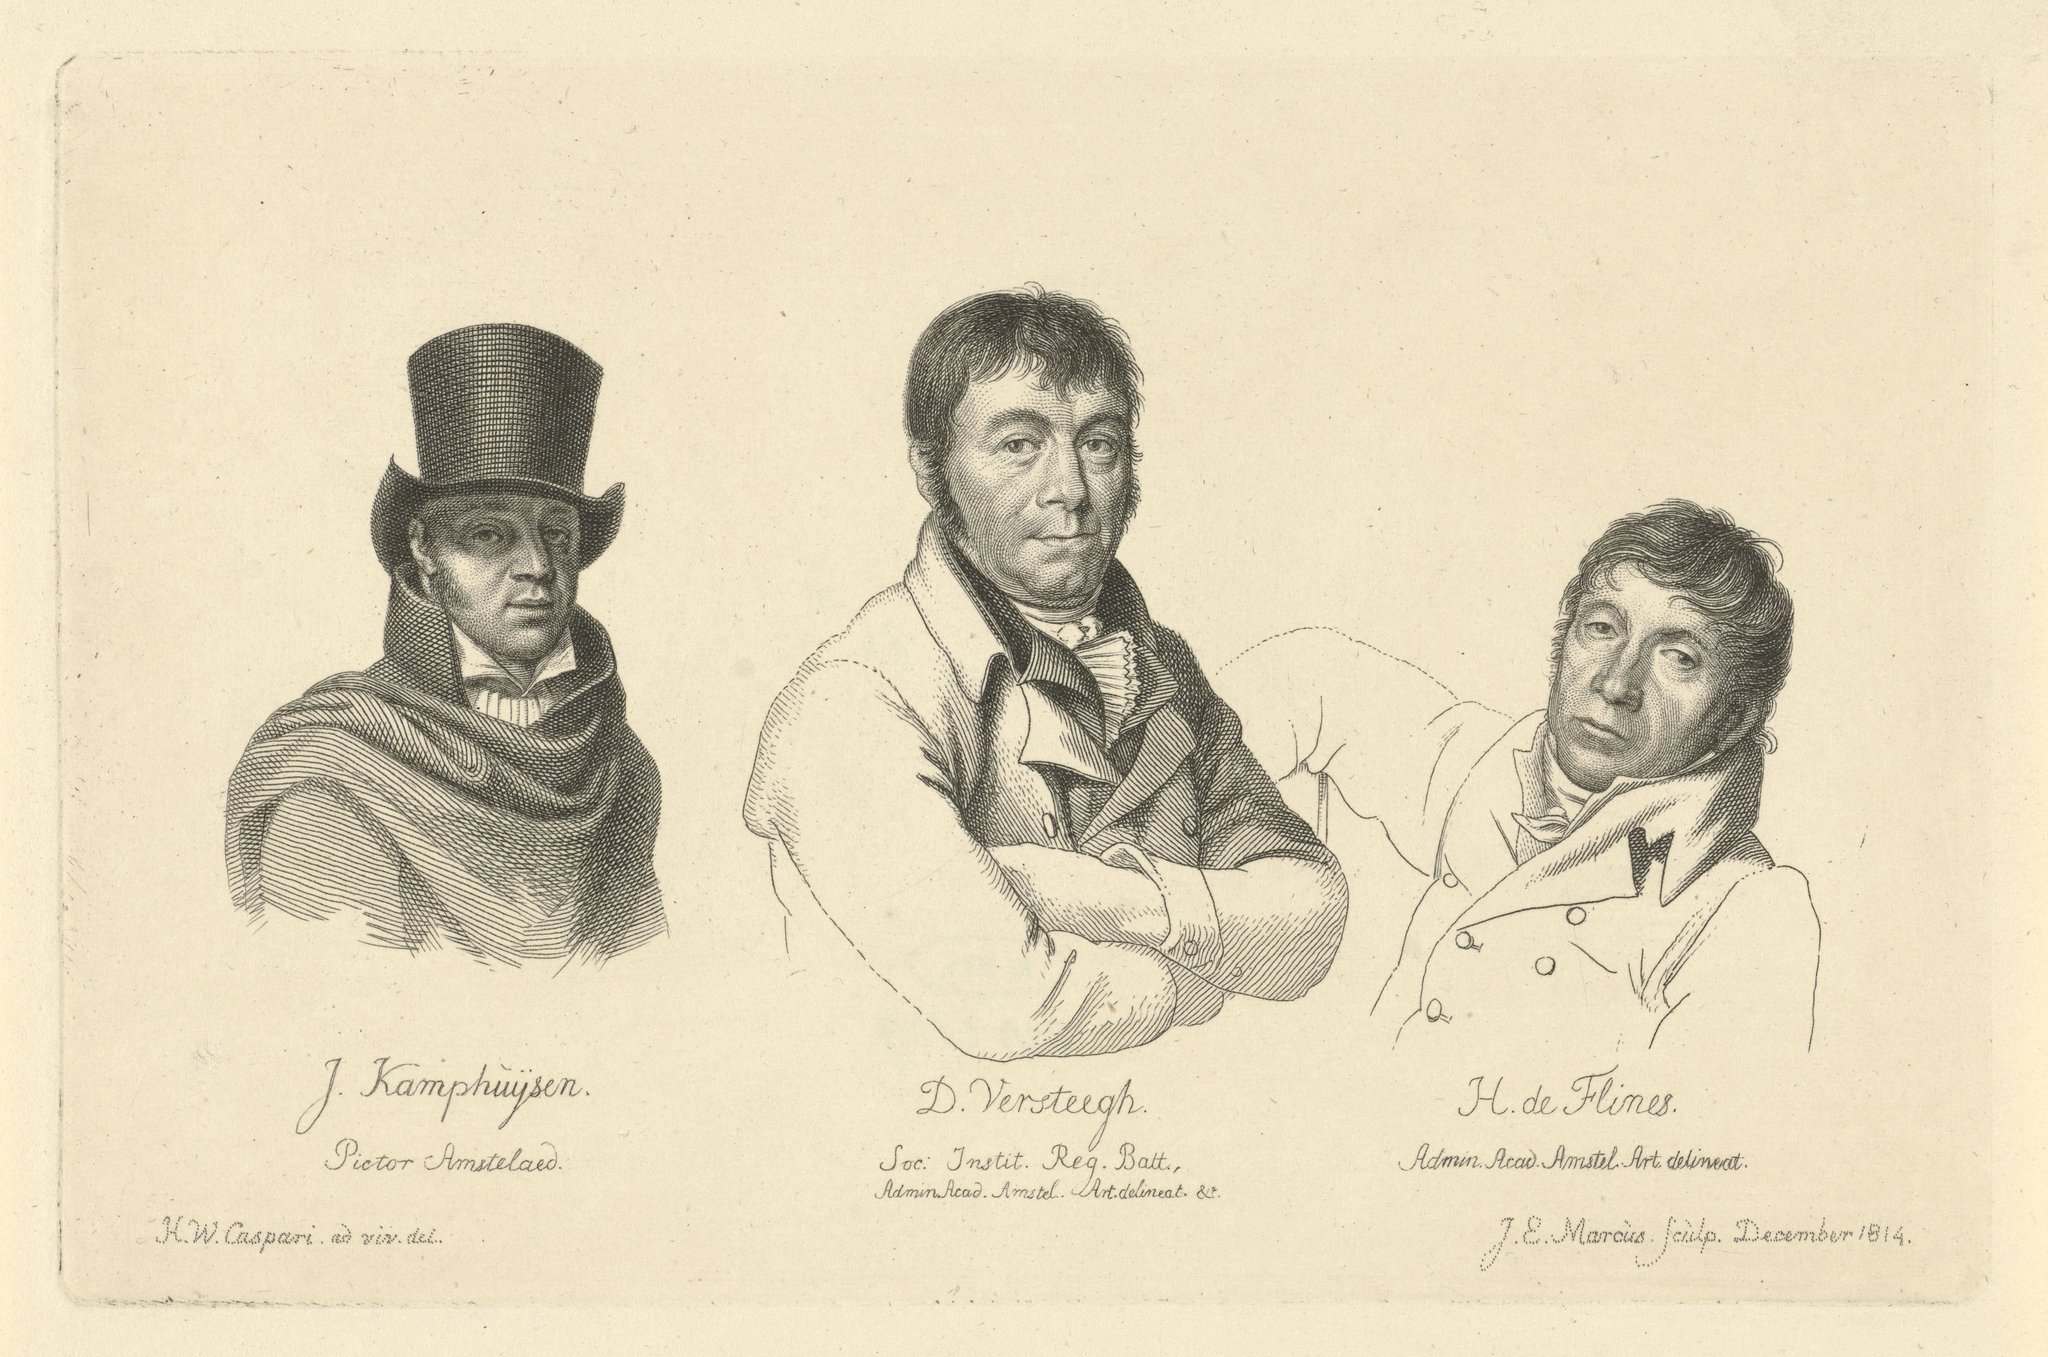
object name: print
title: Studie-prentwerk / Etudes gravées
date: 1812-1814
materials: paper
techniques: etching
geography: amsterdam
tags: painter, jan kamphuijsen, draughtsman, dirk versteegh, hendrik de flines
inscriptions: collector's mark: Lugt 2228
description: Serie voor het eerst uitgegeven door Jacob Ernst Marcus onder de titel Studiebeelden en Fragmenten. Amsterdam: ca.1816. Later heruitgegeven als: Studie-prentwerk/ Etudes gravées.